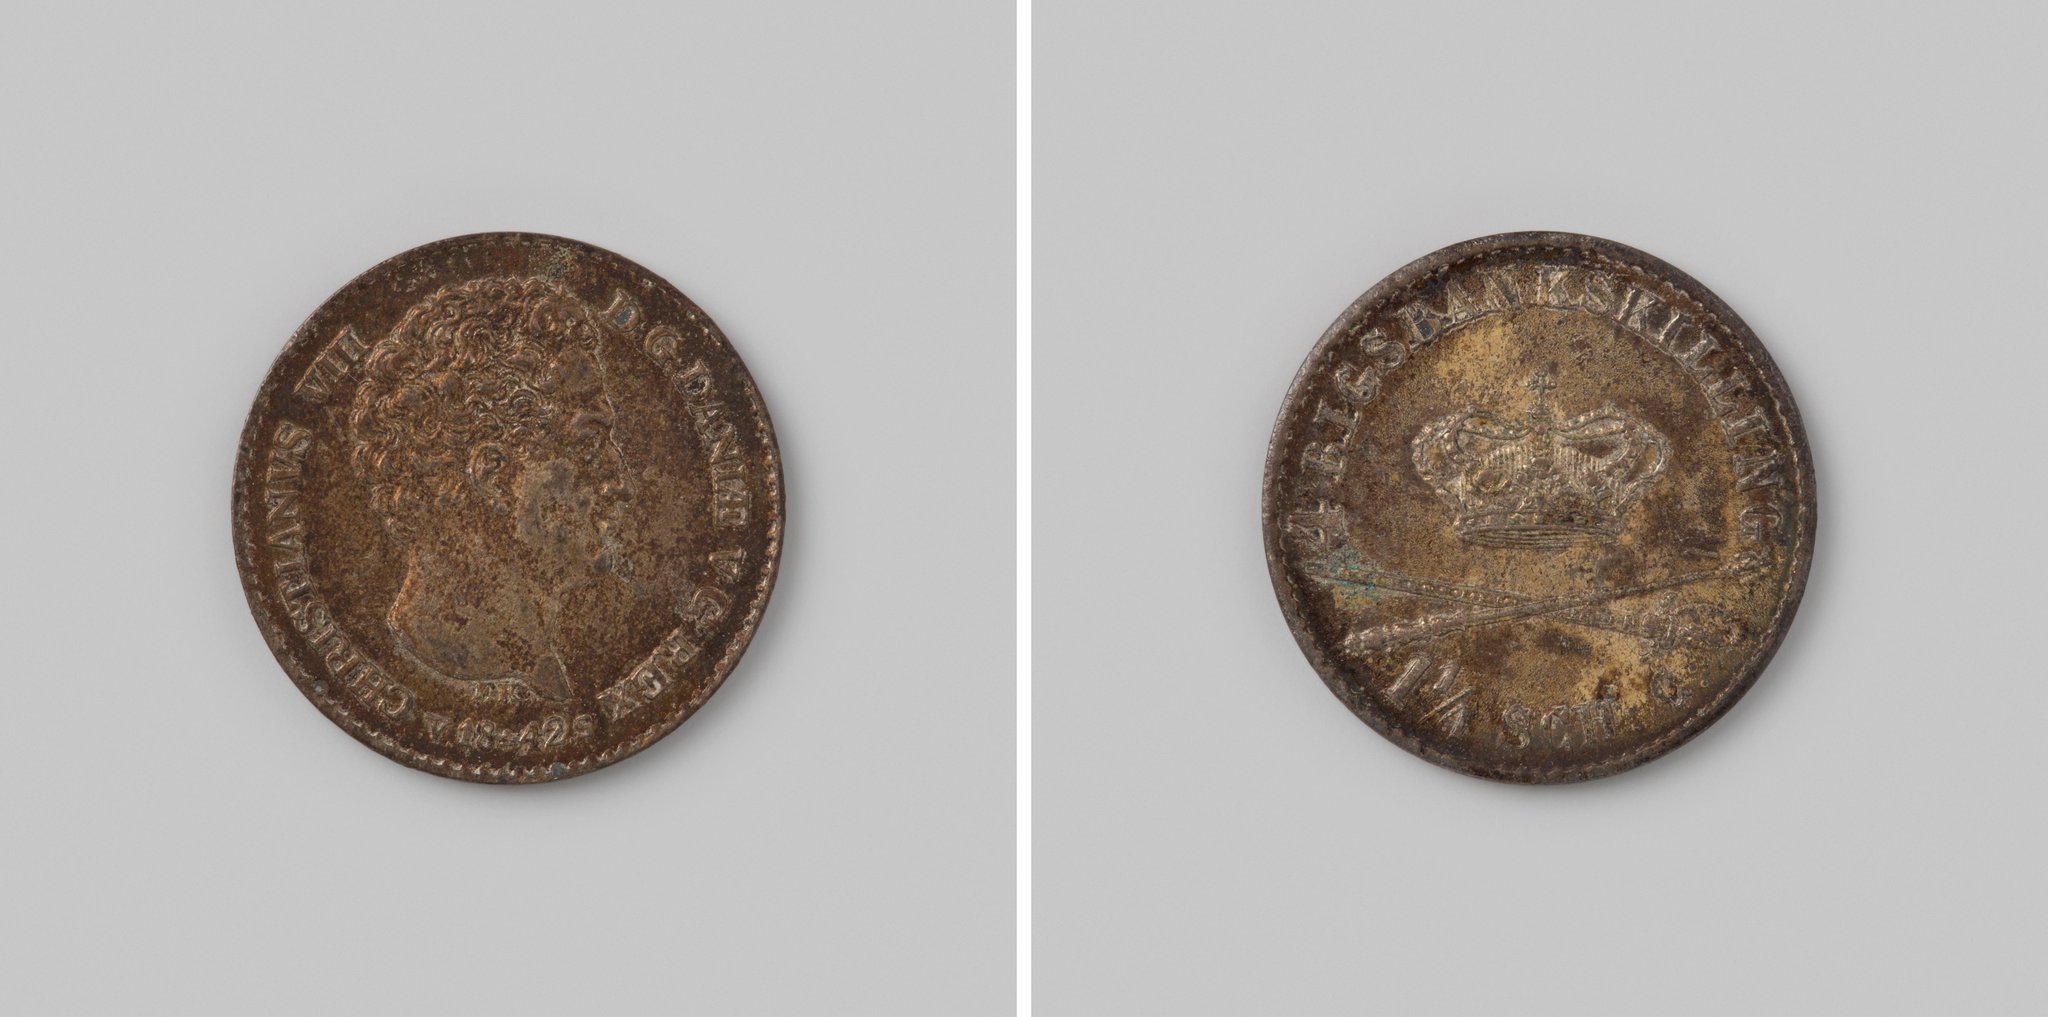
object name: een en een kwart schilling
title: Denemarken, Christiaan VIII, 4 rigsbank skilling of 1 1/4 schilling courant, 1842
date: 1842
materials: silver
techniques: striking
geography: copenhagen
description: Zilveren munt. Voorzijde: hoofd van de koning naar rechts. Daaronder jaartal. Keerzijde: twee gekruiste scepters, waarboven kroon. Beide waarde-aanduidingen als omschrift. Gladde rand.